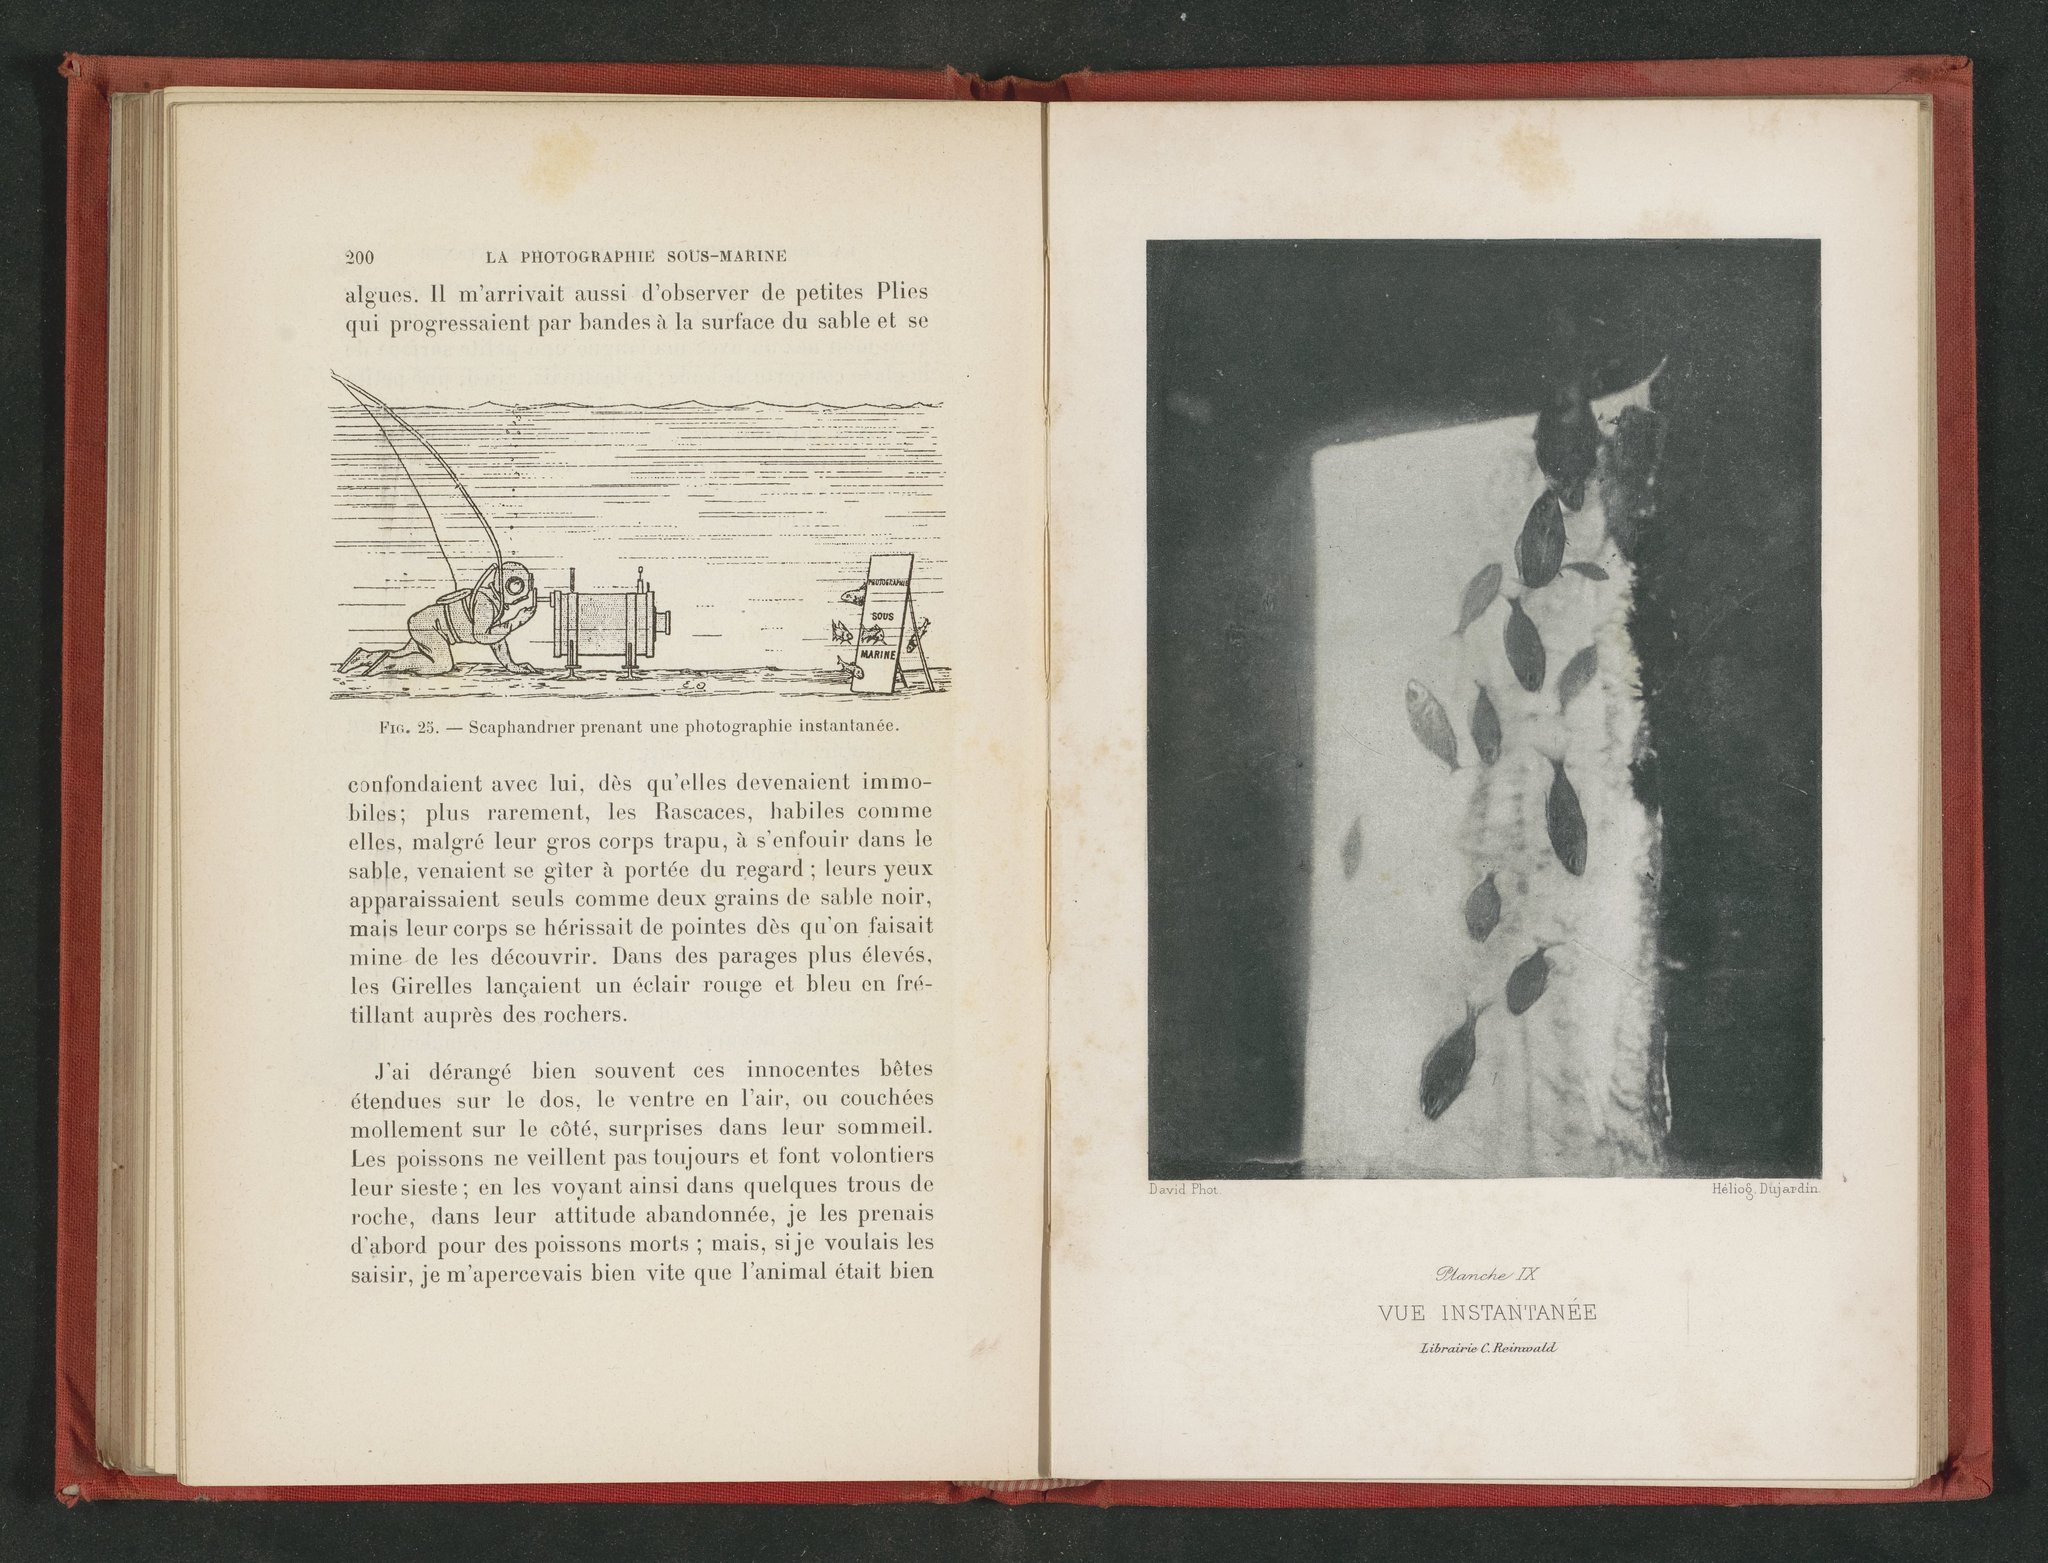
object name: page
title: Vissen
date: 1890-1900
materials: paper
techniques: photoaquatint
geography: france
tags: fishes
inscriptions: number: ‘Planche IX’, inscription: ‘Librairie C. Reinwald’